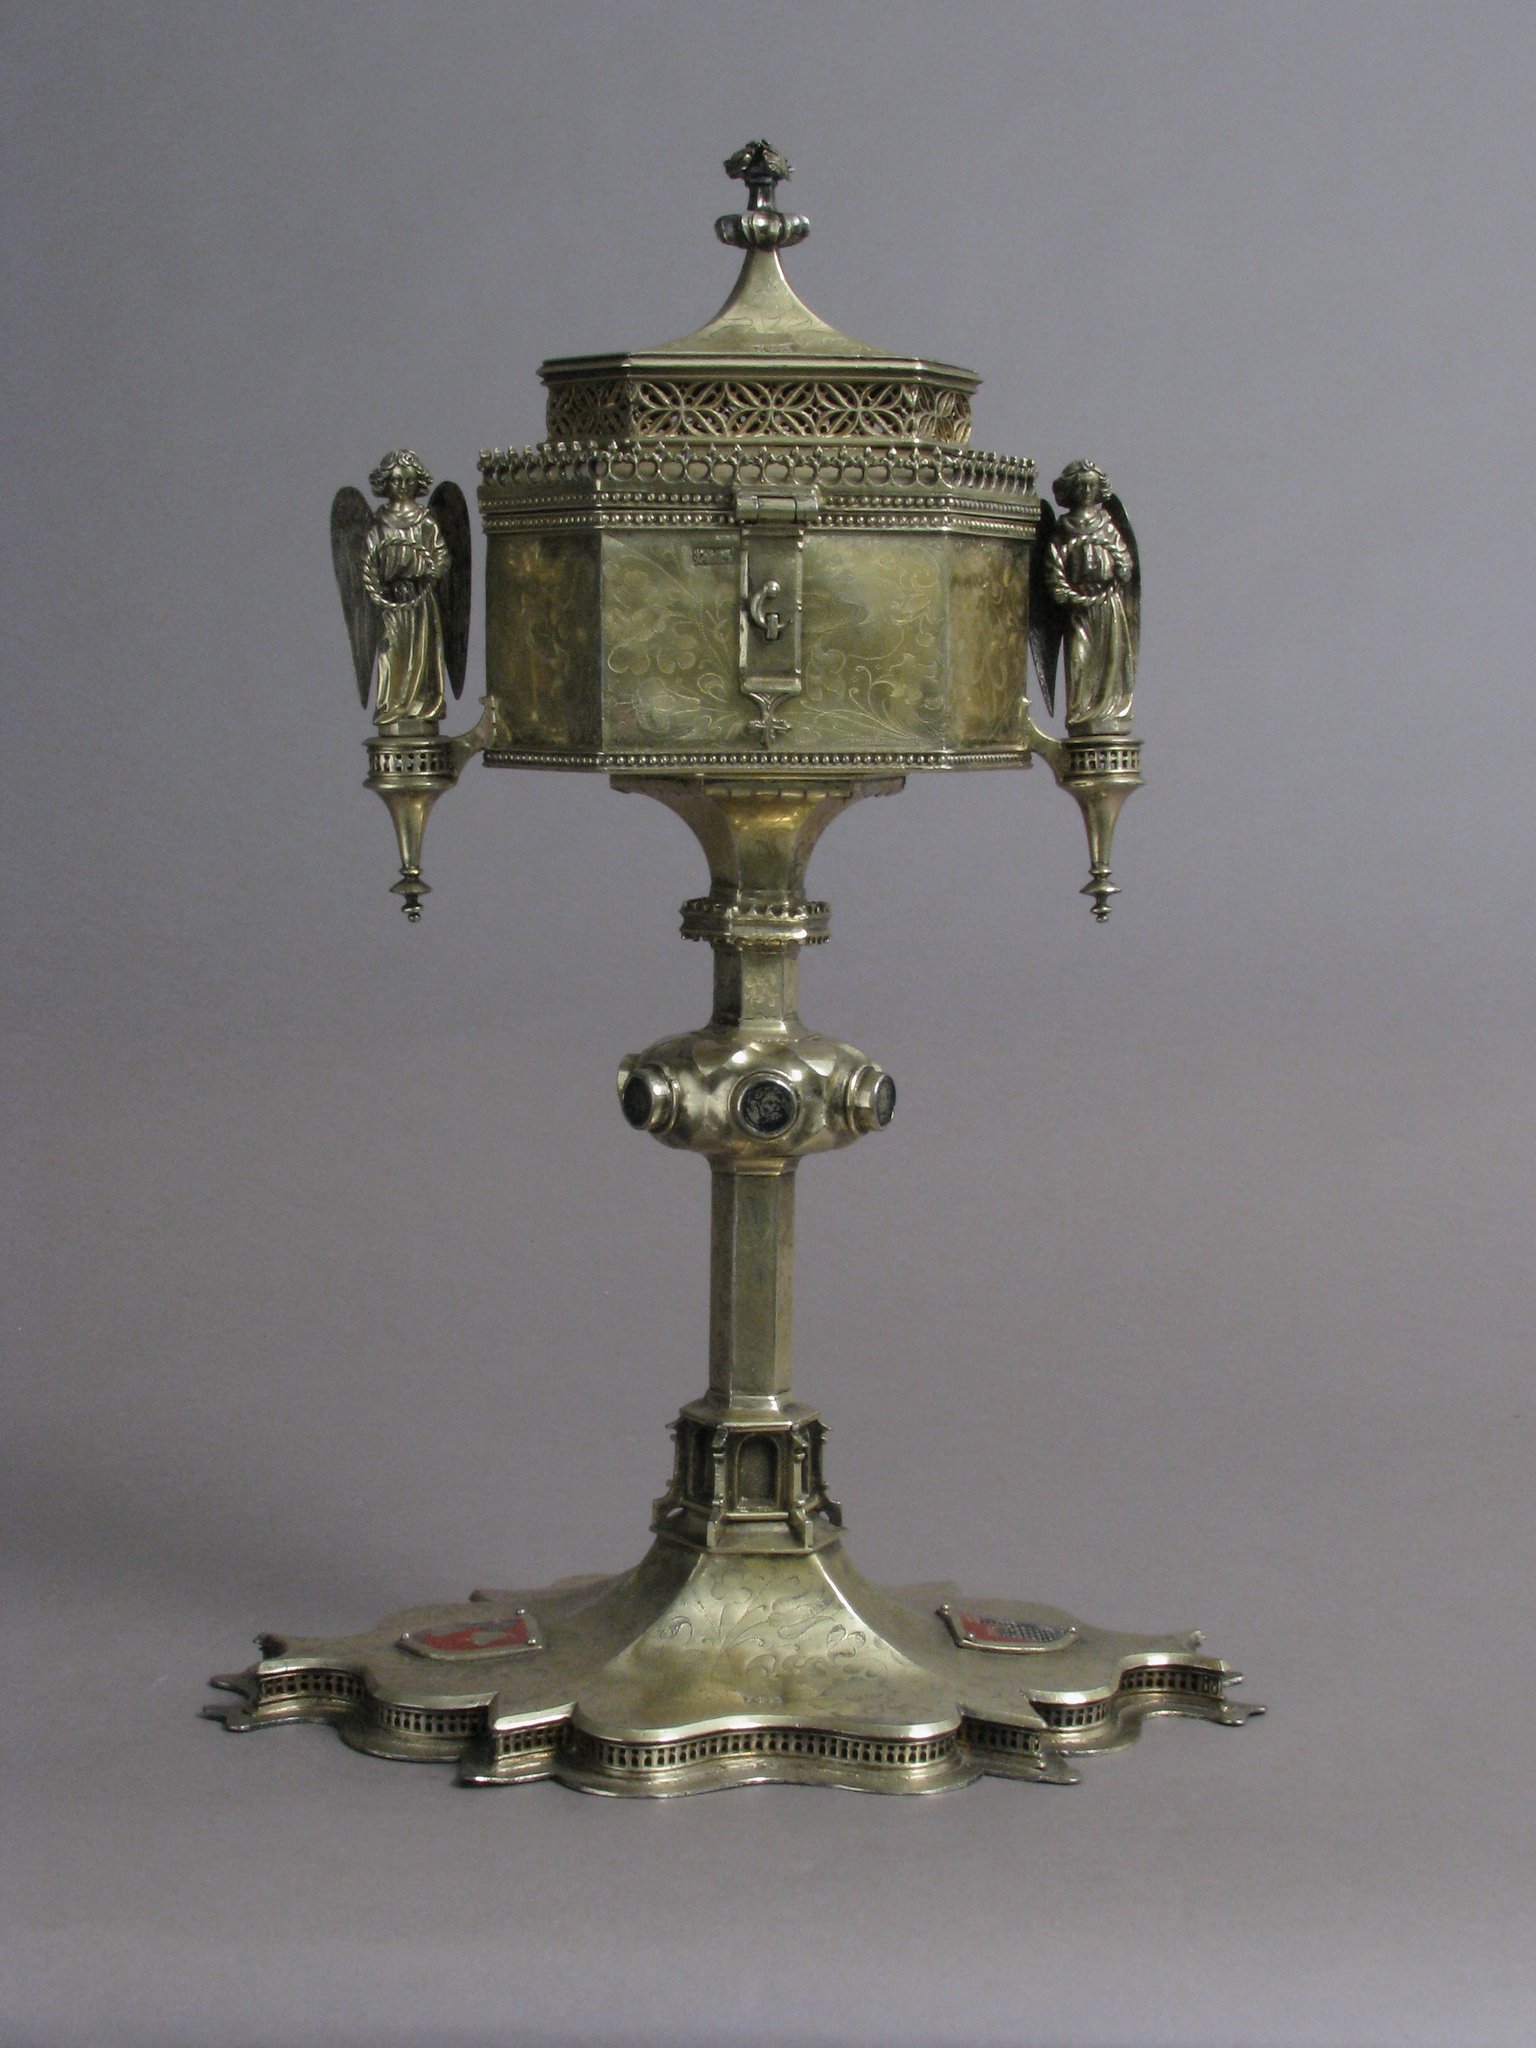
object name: pyx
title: Footed Pyx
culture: spanish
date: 1801-2000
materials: enamel, silver, silver gilt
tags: angels,coat of arms